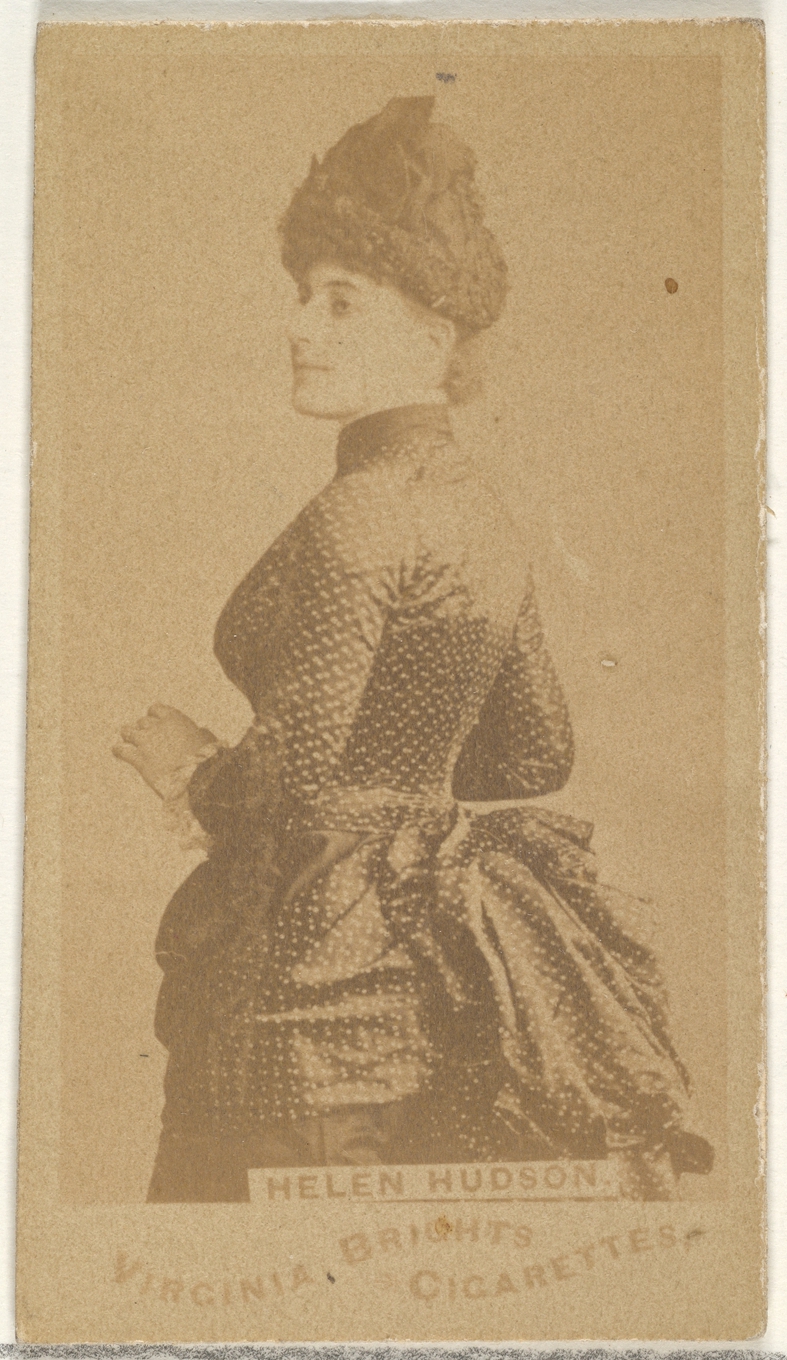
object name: photograph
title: Helen Hudson, from the Actors and Actresses series (N45, Type 1) for Virginia Brights Cigarettes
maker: allen & ginter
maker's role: publisher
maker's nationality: american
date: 1888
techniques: albumen silver print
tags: portraits,profiles,women,actresses